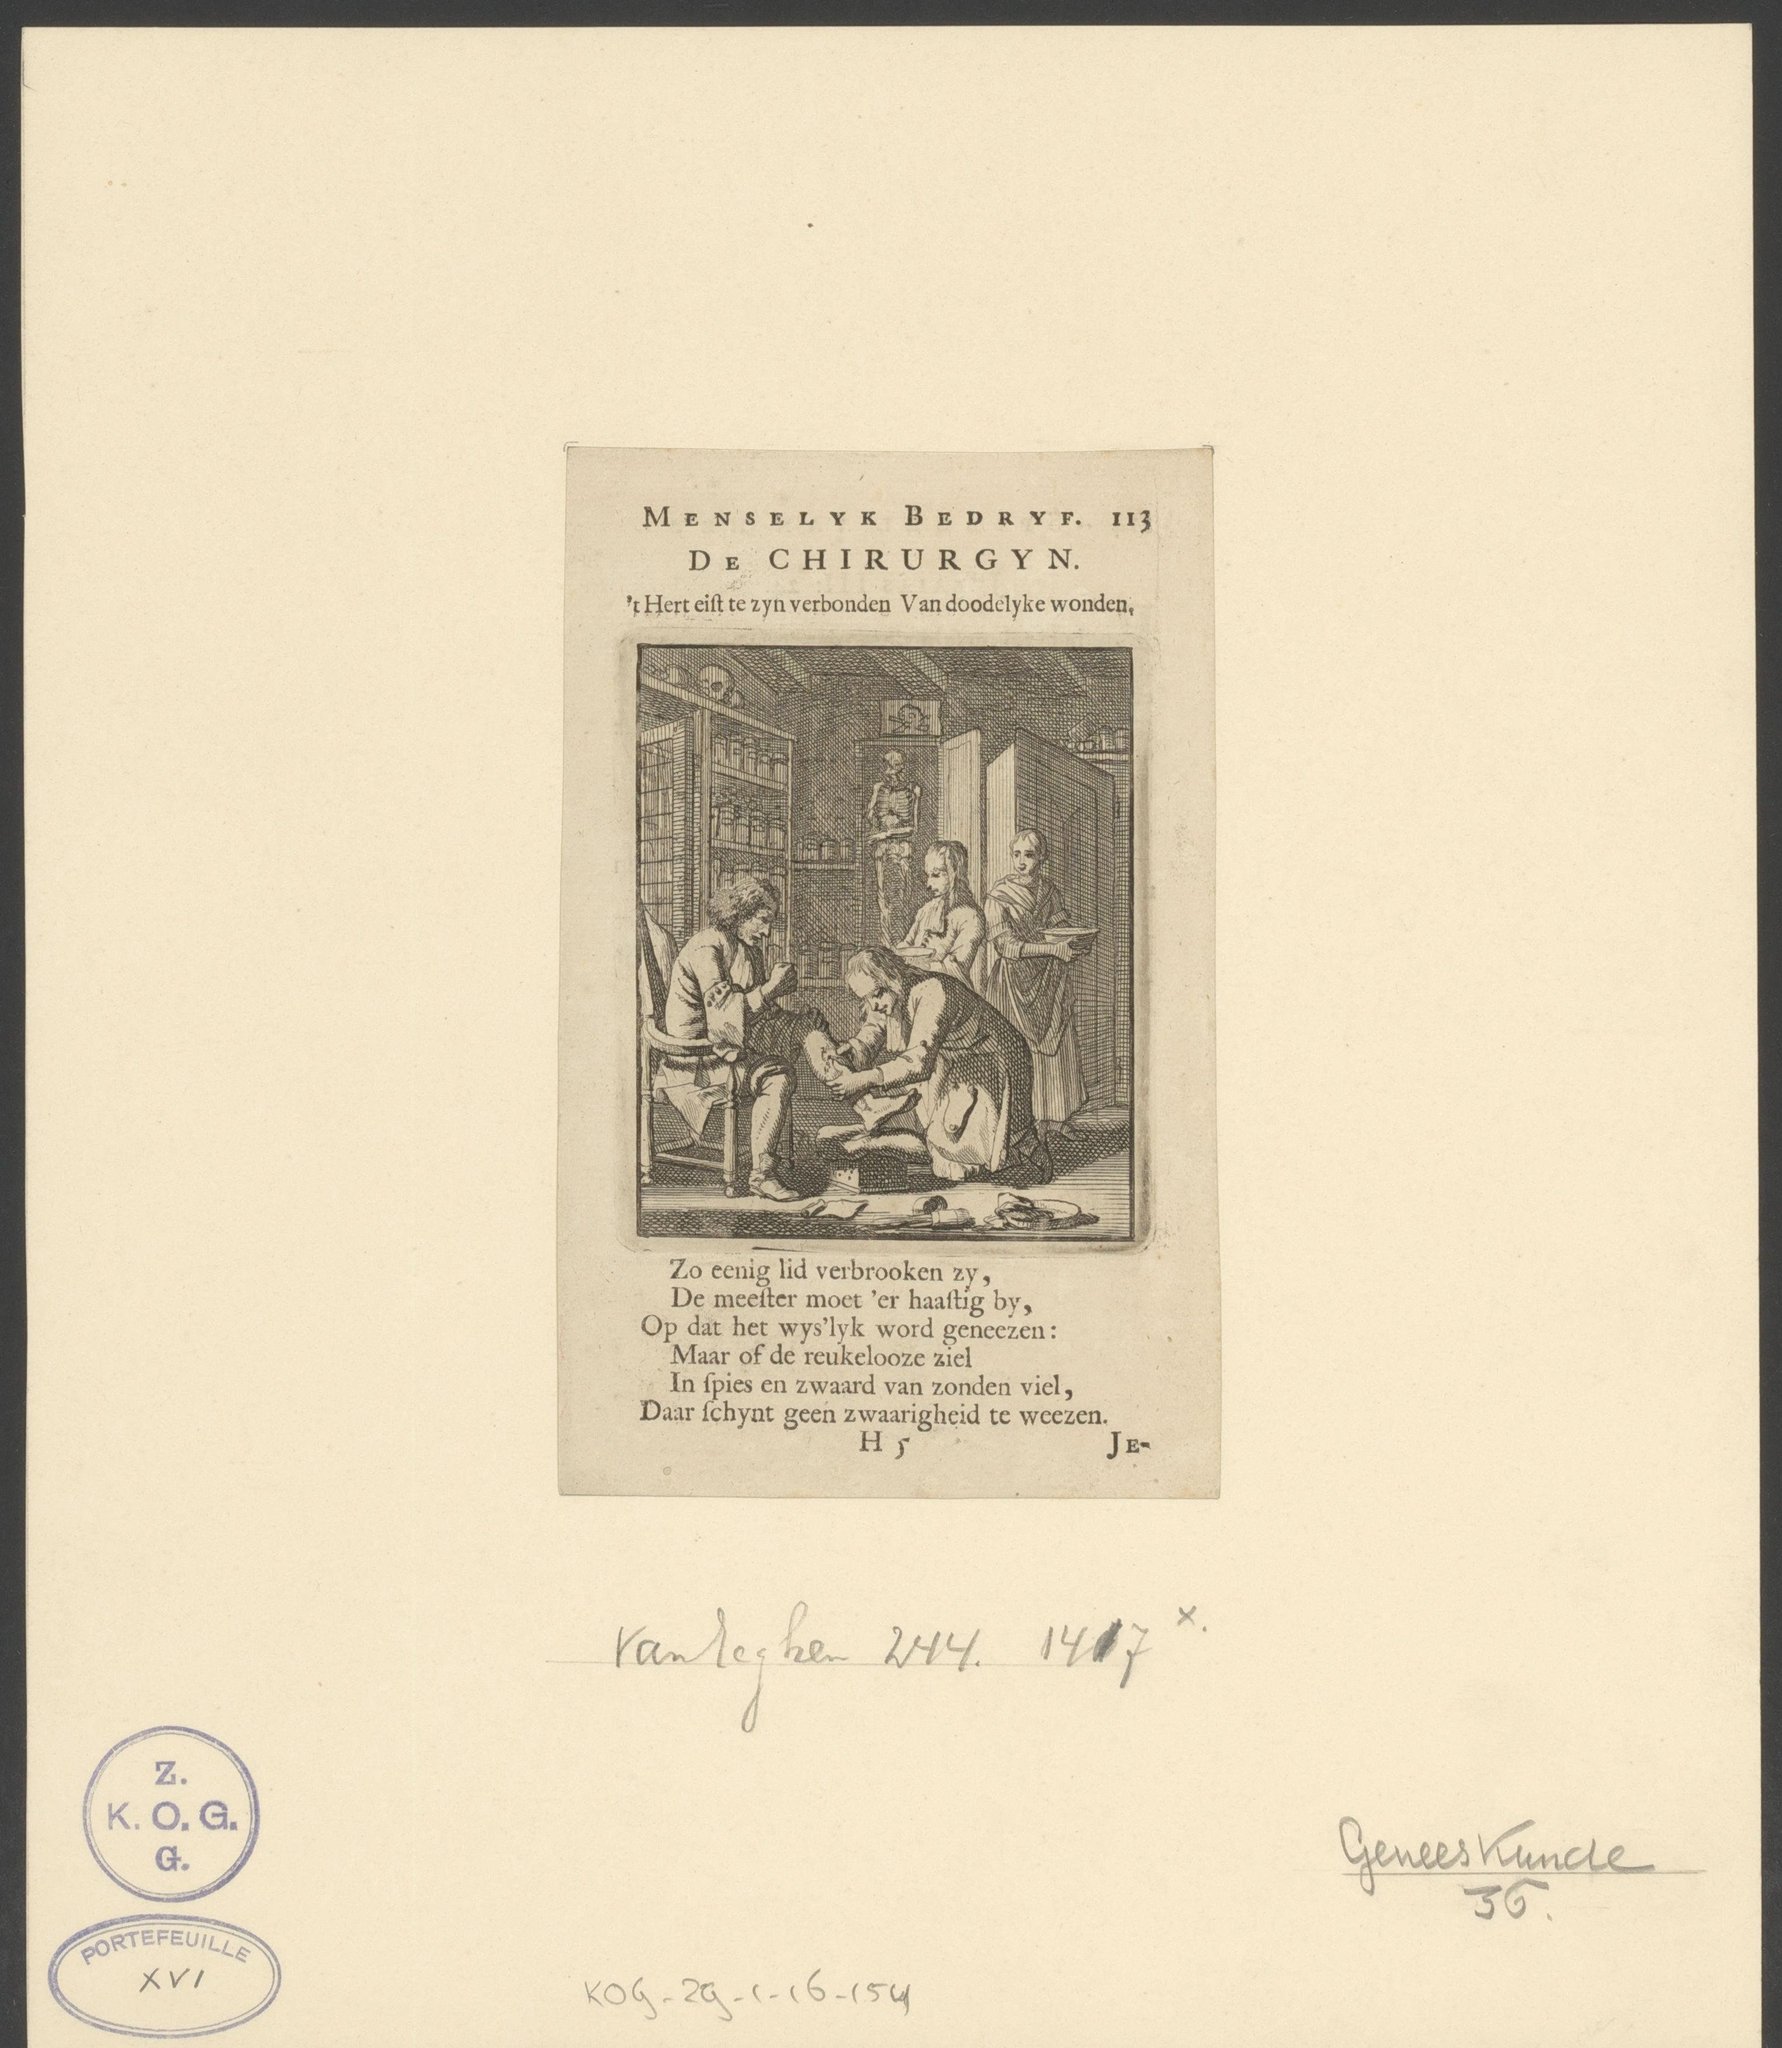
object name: print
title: De Chirurgyn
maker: jan luyken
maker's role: draughtsman, print maker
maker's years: 1649-1712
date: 1694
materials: paper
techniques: engraving, etching, letterpress printing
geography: amsterdam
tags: barber; surgeon, examination, diagnosis; physician speaking with patient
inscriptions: collector's mark: Lugt 1641, collector's mark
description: Een chirurgijn of arts behandelt een wond aan het been van een man. Met zesregelig vers onder de plaat. Genummerd rechtsboven: 113. Bedrukt met tekst op achterzijde. Onderwerpsrubrieken binnen de Atlas Zeden en Gewoonten: Onderwijs en Wetenschappen: Geneeskunde.